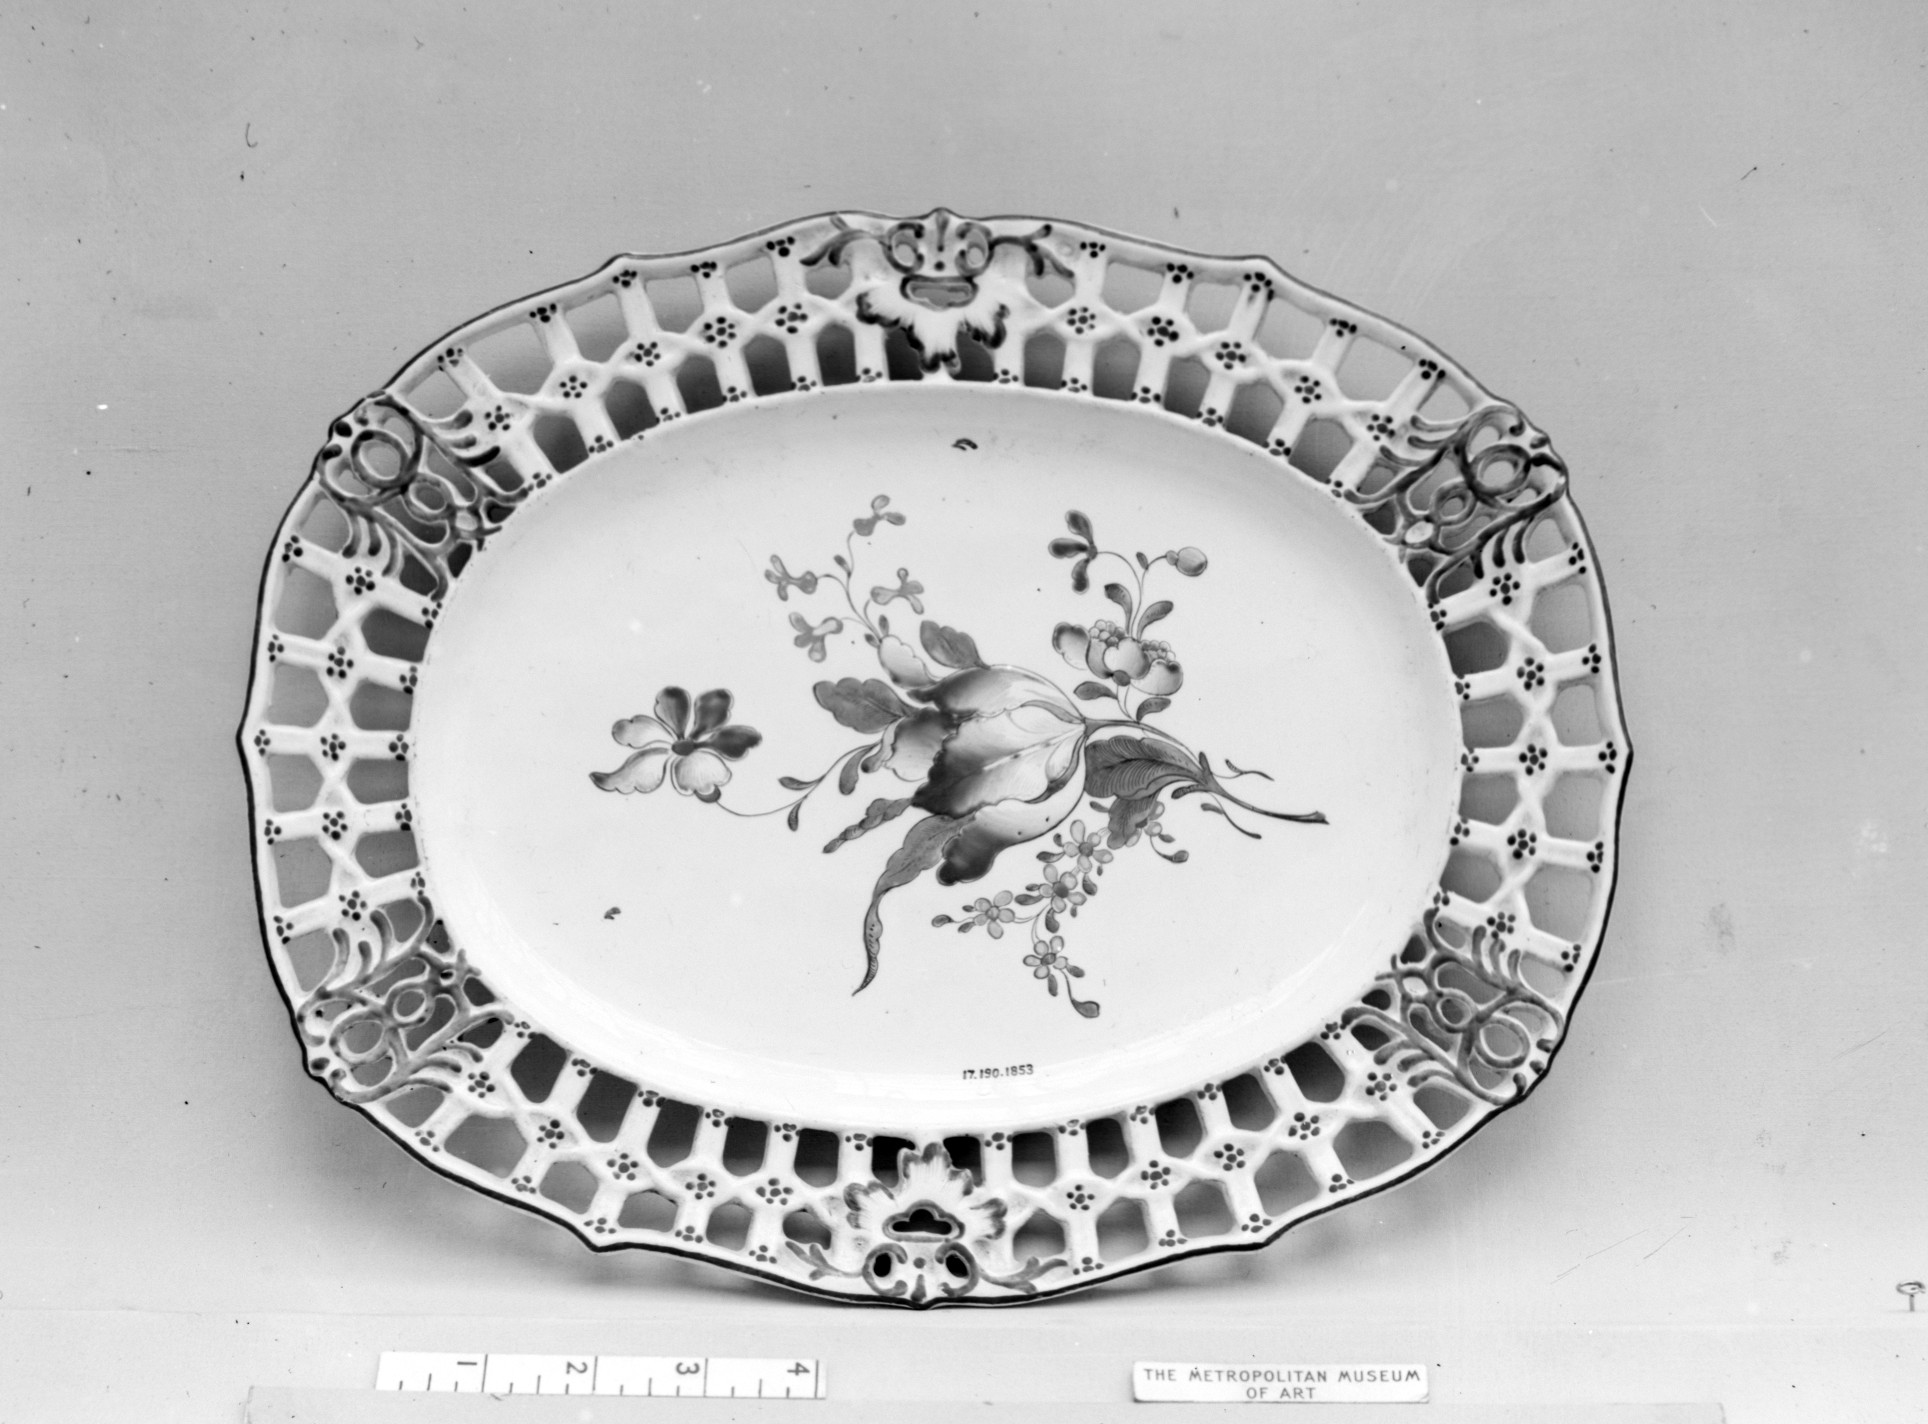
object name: tray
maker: joseph hannong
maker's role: maker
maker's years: 1755-1780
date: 1701-1800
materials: faience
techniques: glazing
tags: flowers